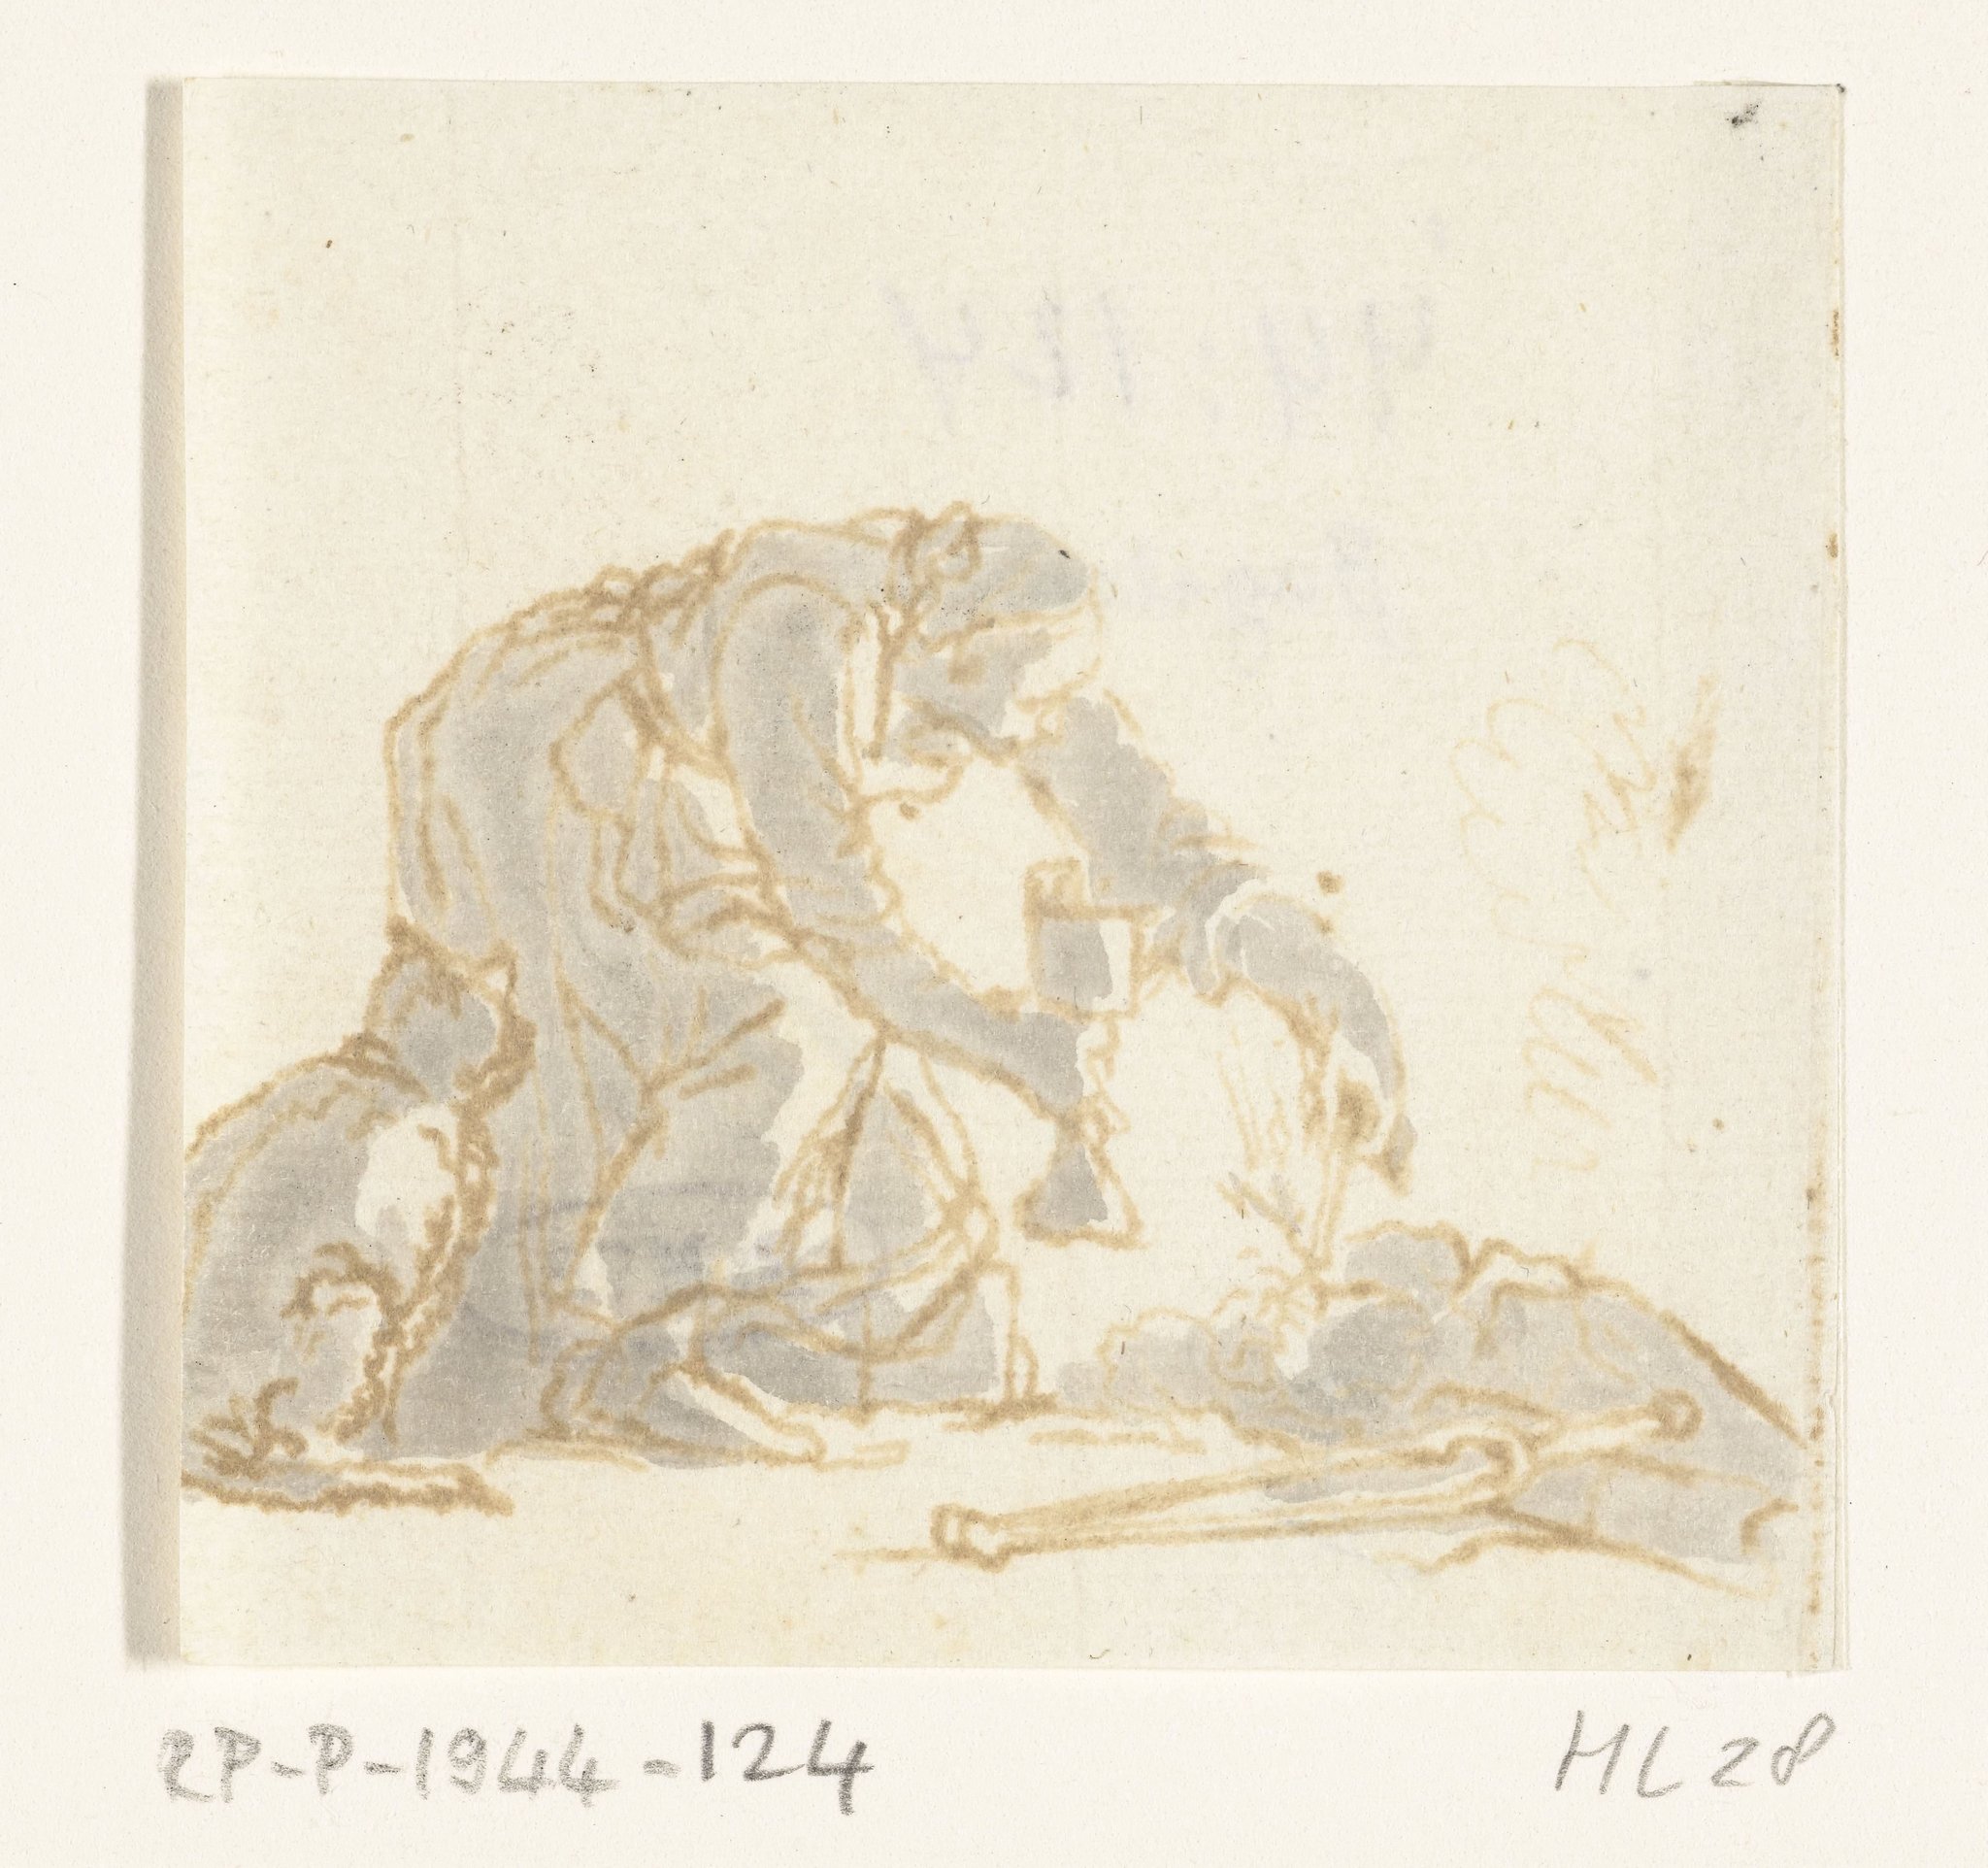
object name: print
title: Vrouw met zwavelstok en lamp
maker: ernst willem jan bagelaar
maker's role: draughtsman, print maker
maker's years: 1775-1837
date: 1798-1837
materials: paper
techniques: aquatint, etching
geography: netherlands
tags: witch, sorceress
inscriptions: collector's mark: Lugt 2228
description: Een vrouw staat voorovergebogen, in haar ene hand een lamp, in de andere een zwavelstokje. Naast haar zit een poes.